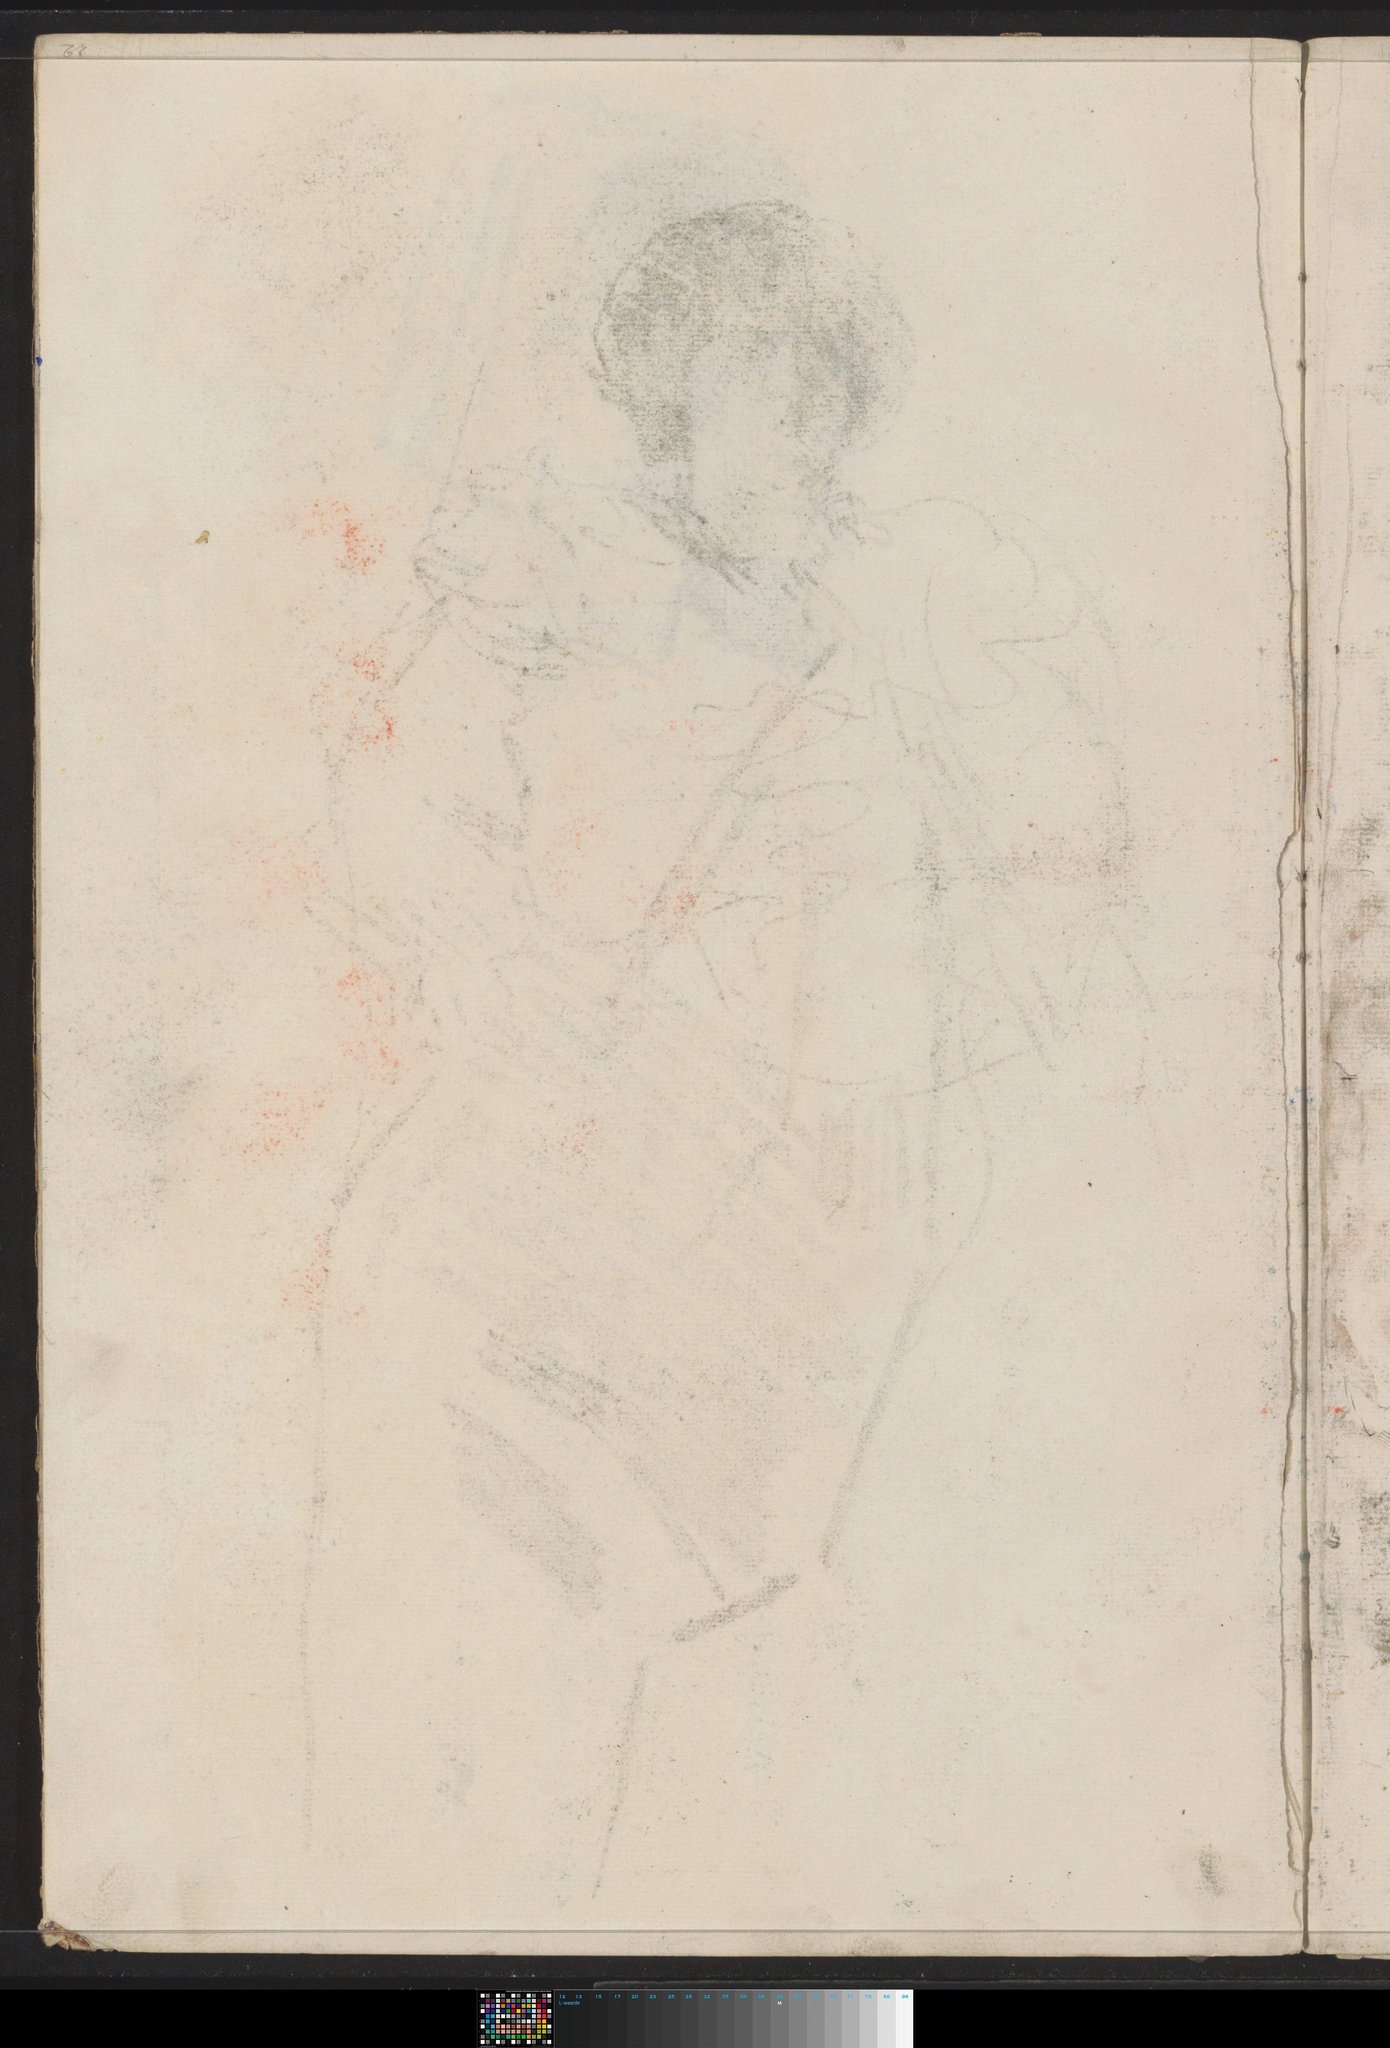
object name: sketchbook leaf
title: Abklatsch van een krijttekening van een vrouw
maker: isaac israels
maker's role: draughtsman, painter, print maker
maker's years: 1865-1934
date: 1875-1934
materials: paper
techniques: printmaking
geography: the hague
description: De originele tekening is niet meer in het schetsboek aanwezig. Blad 1 verso uit schetsboek LXVIII met 11 bladen.